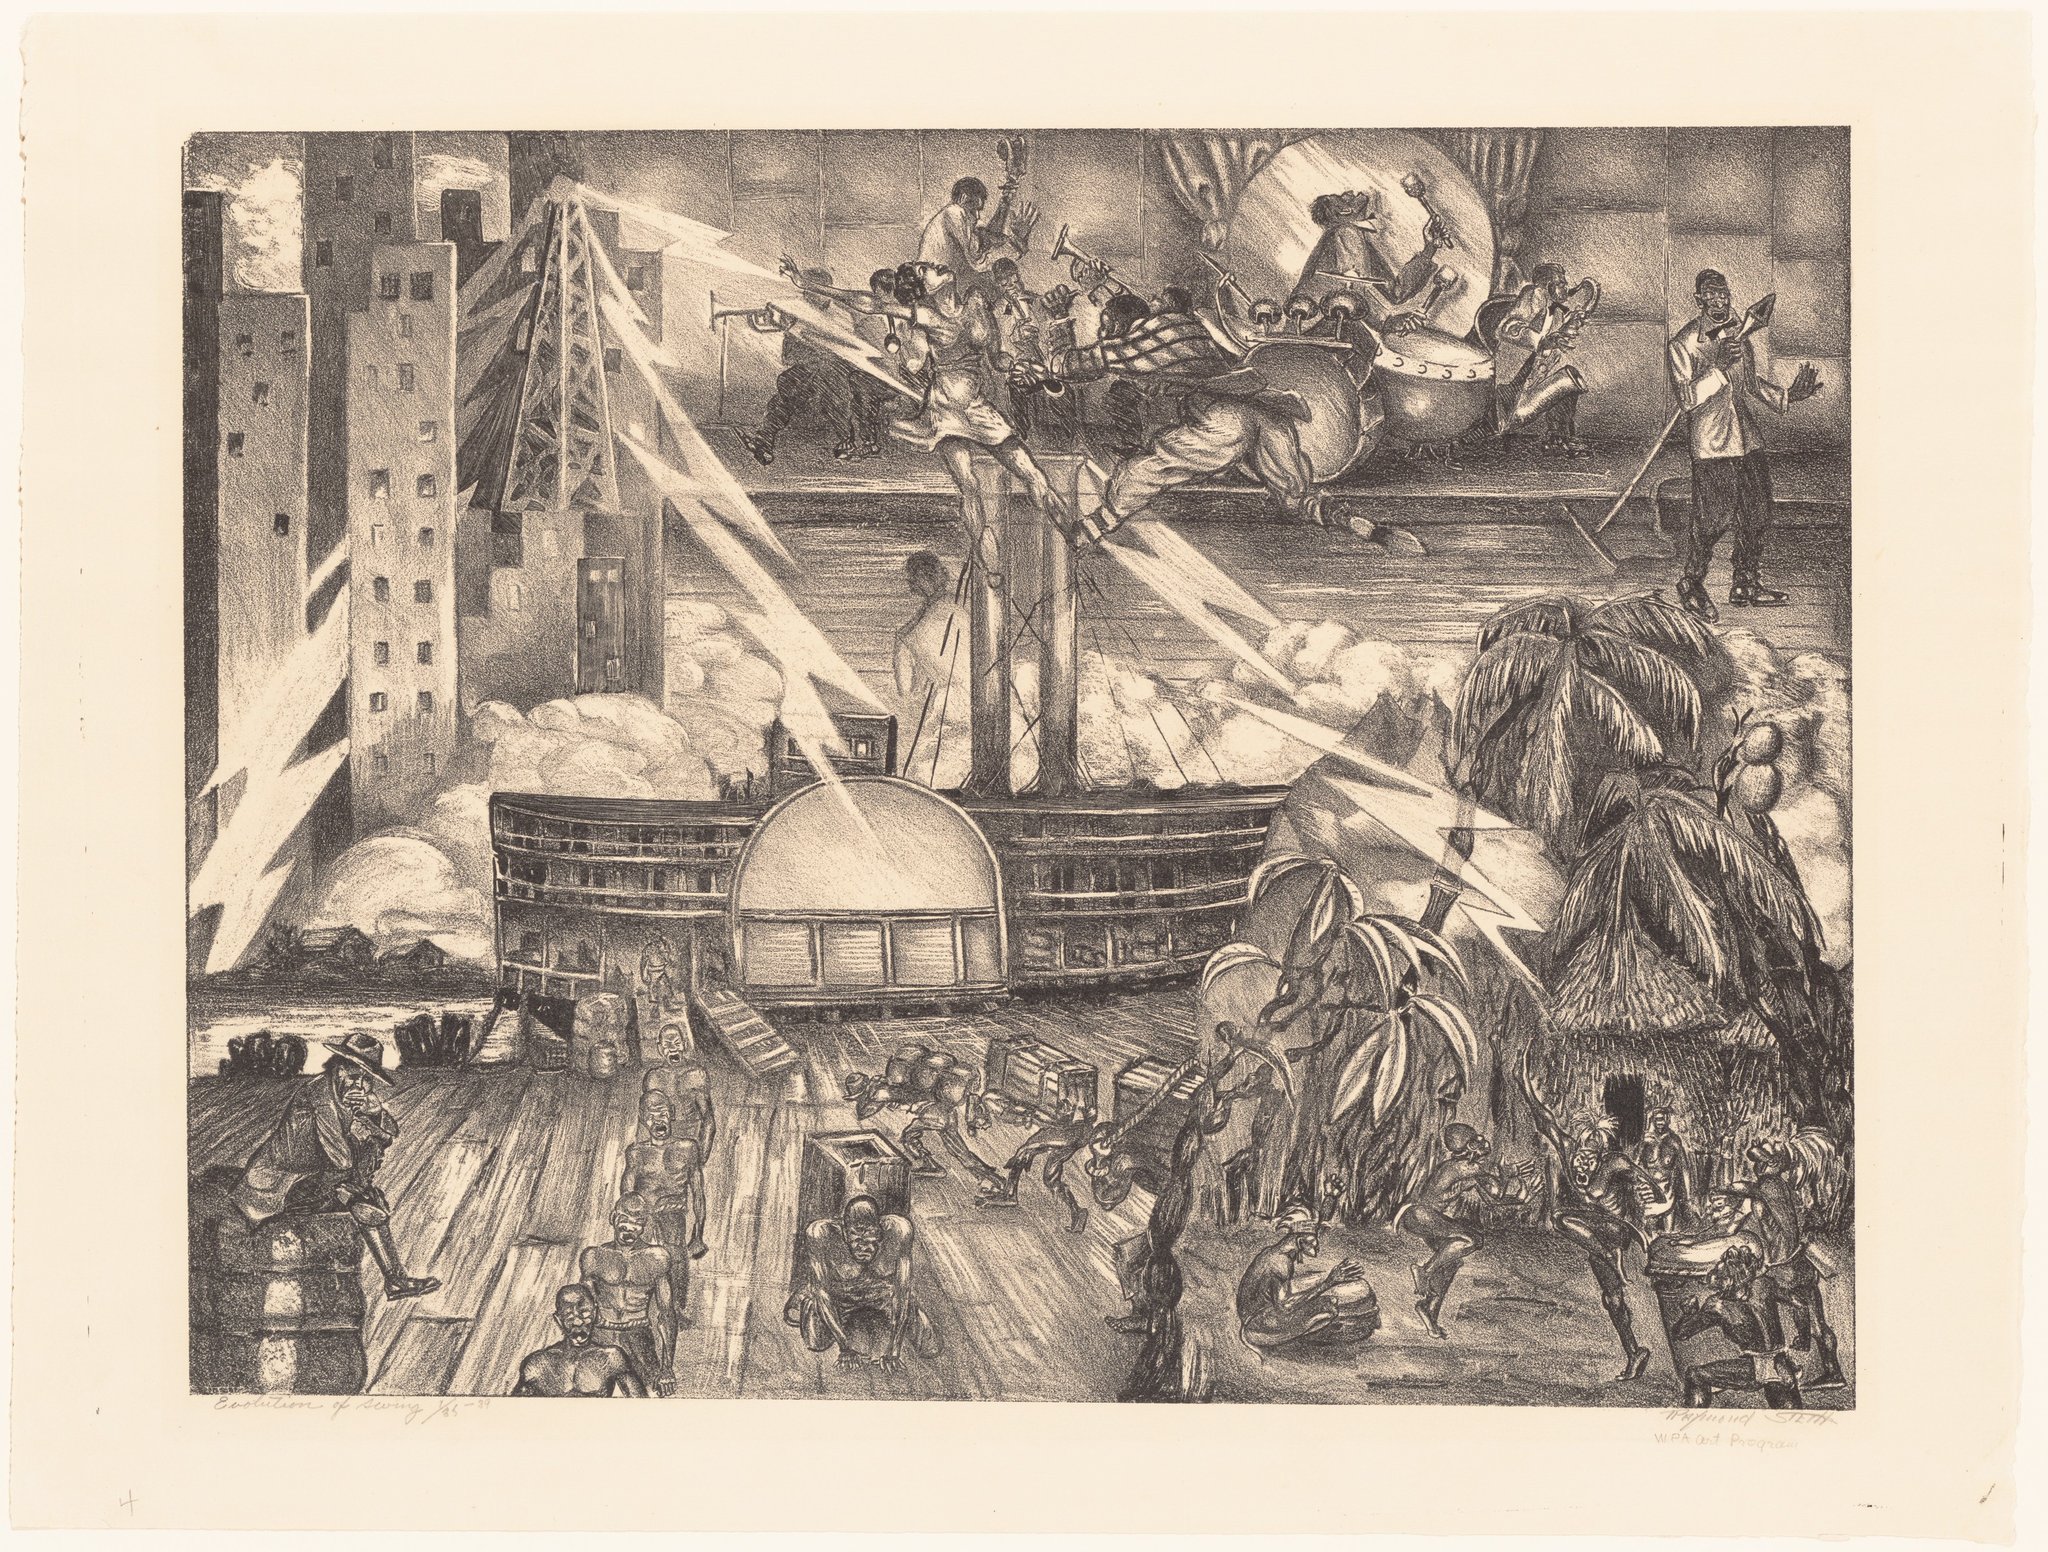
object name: print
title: Evolution of Swing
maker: raymond steth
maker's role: artist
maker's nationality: american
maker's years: 1917-1997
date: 1939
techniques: lithograph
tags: men,women,dancing,musicians,boats,slaves